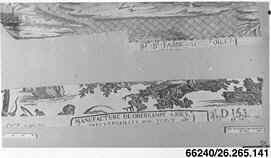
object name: furnishing textile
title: Pictorial print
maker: jean-baptiste huet i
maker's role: designer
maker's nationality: french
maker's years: 1745-1811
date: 1701-1800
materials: linen